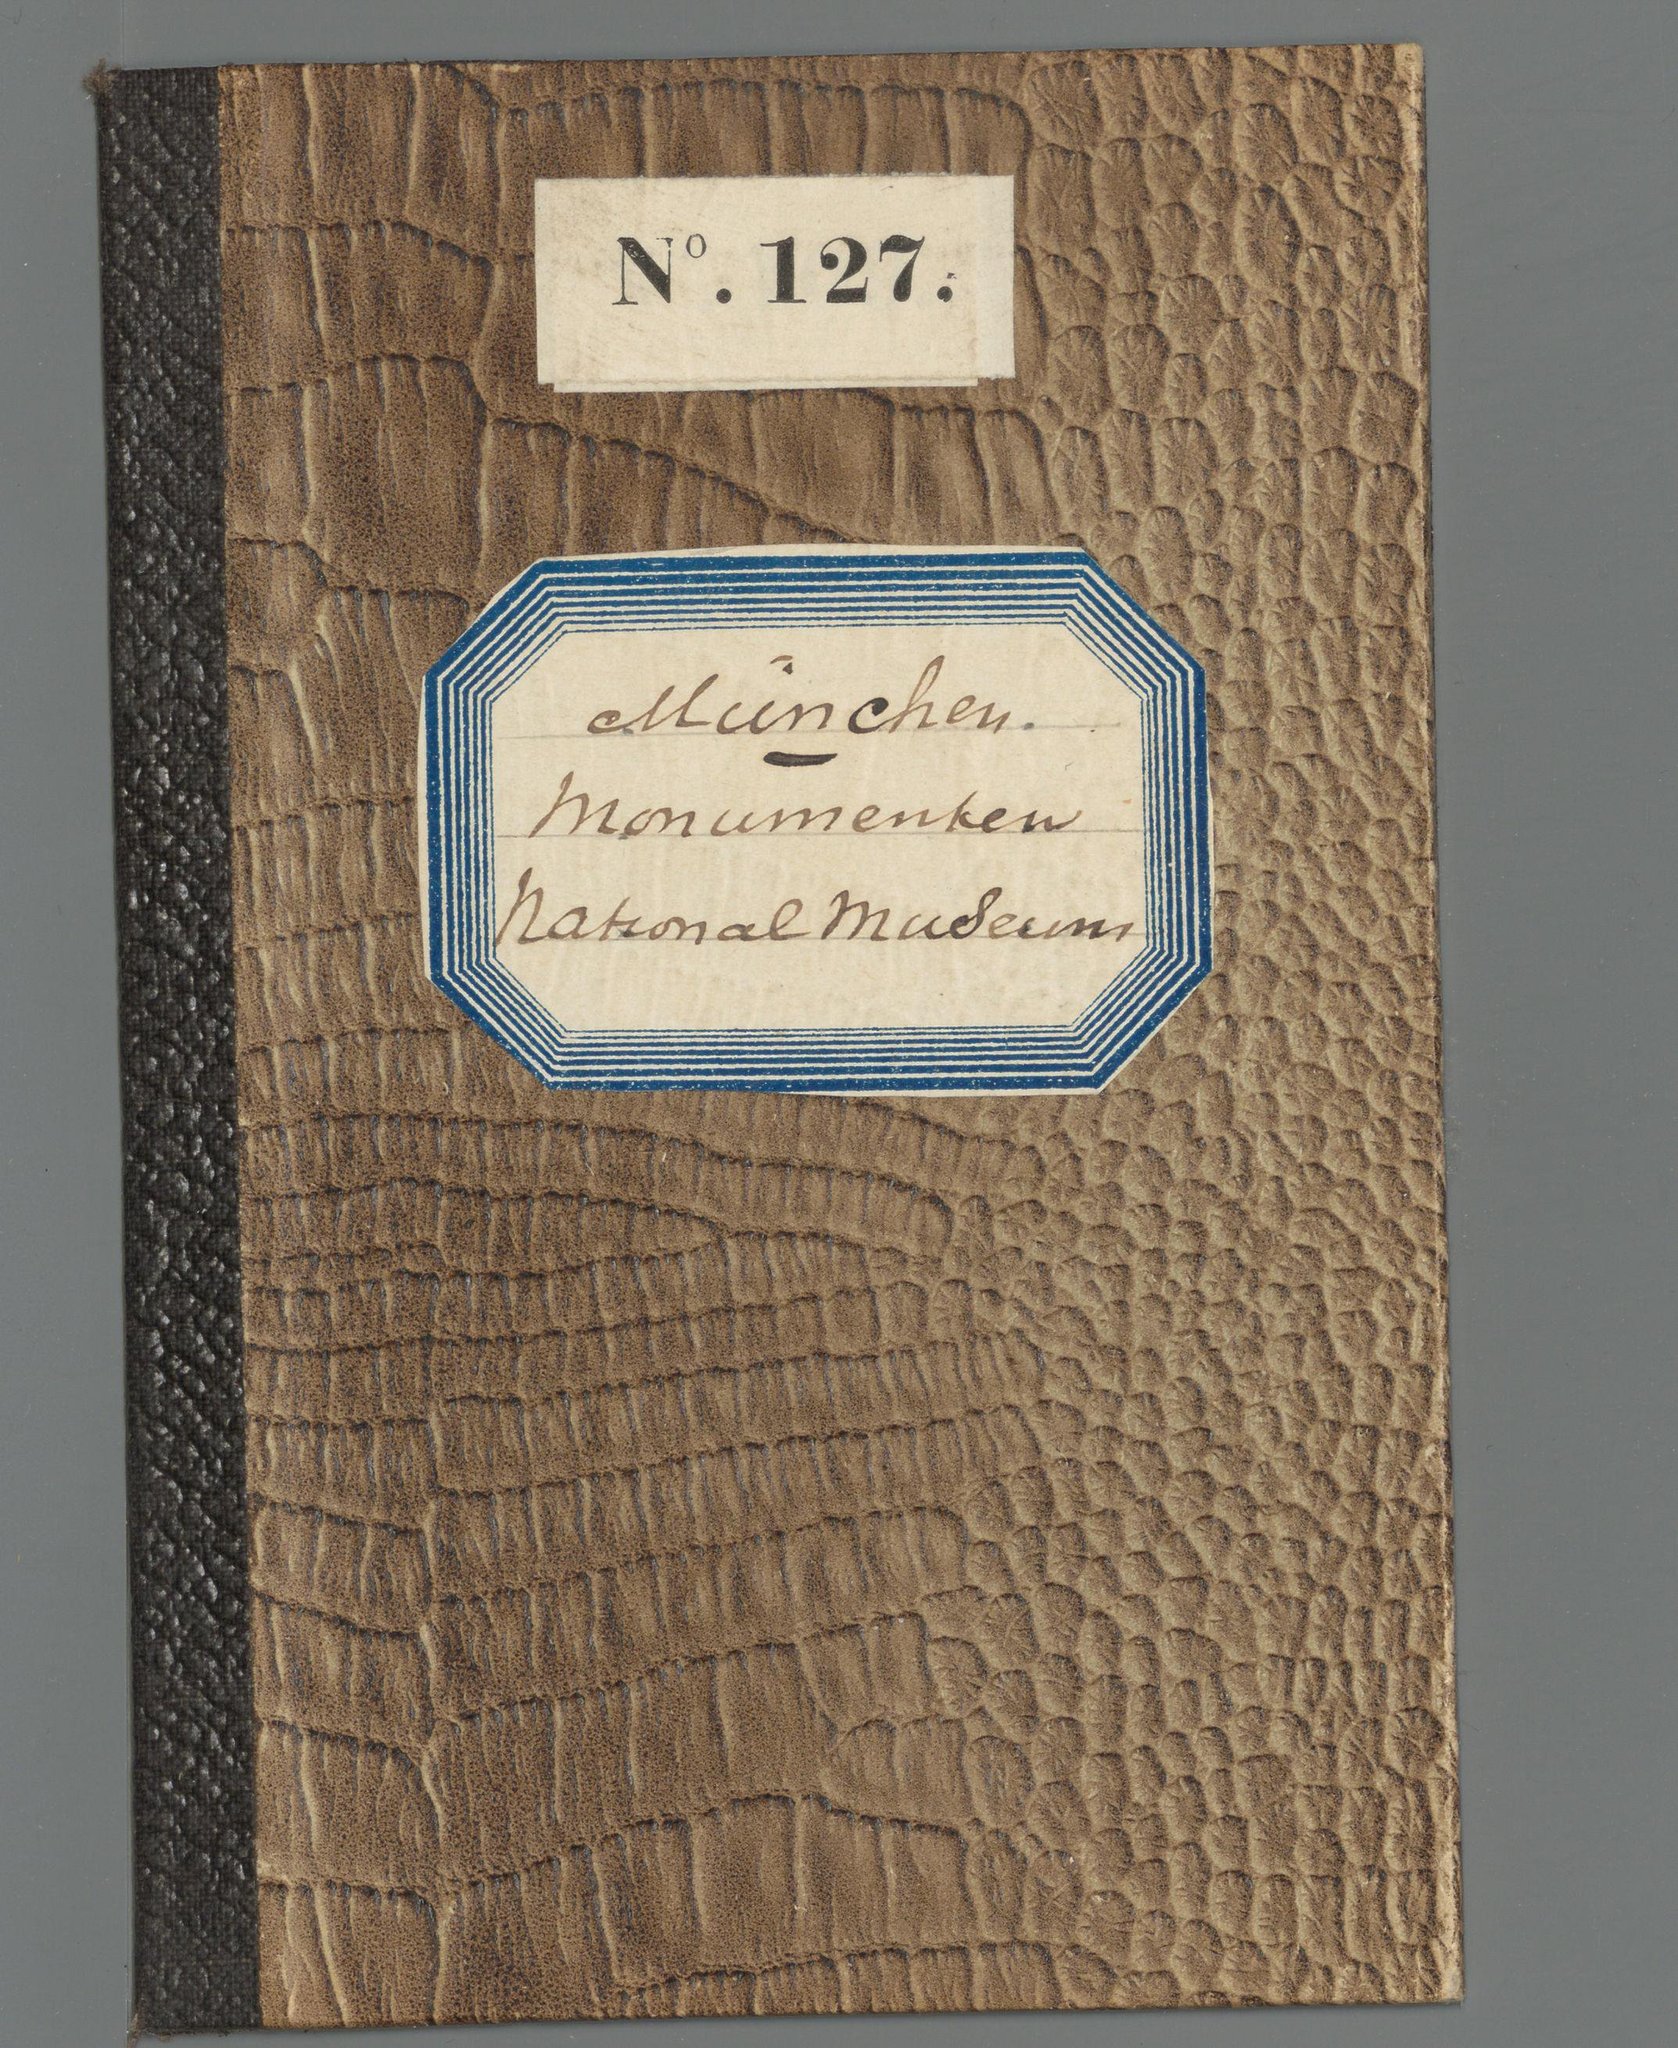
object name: wrapper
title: Omslag voor 32 prentbriefkaarten met stadsgezichten uit München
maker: Anonymous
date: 1900-1950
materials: cardboard, paper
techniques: lithograph, writing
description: In de omslag zit een kaart ingestoken met daarop een korte beschrijving van de inhoud.